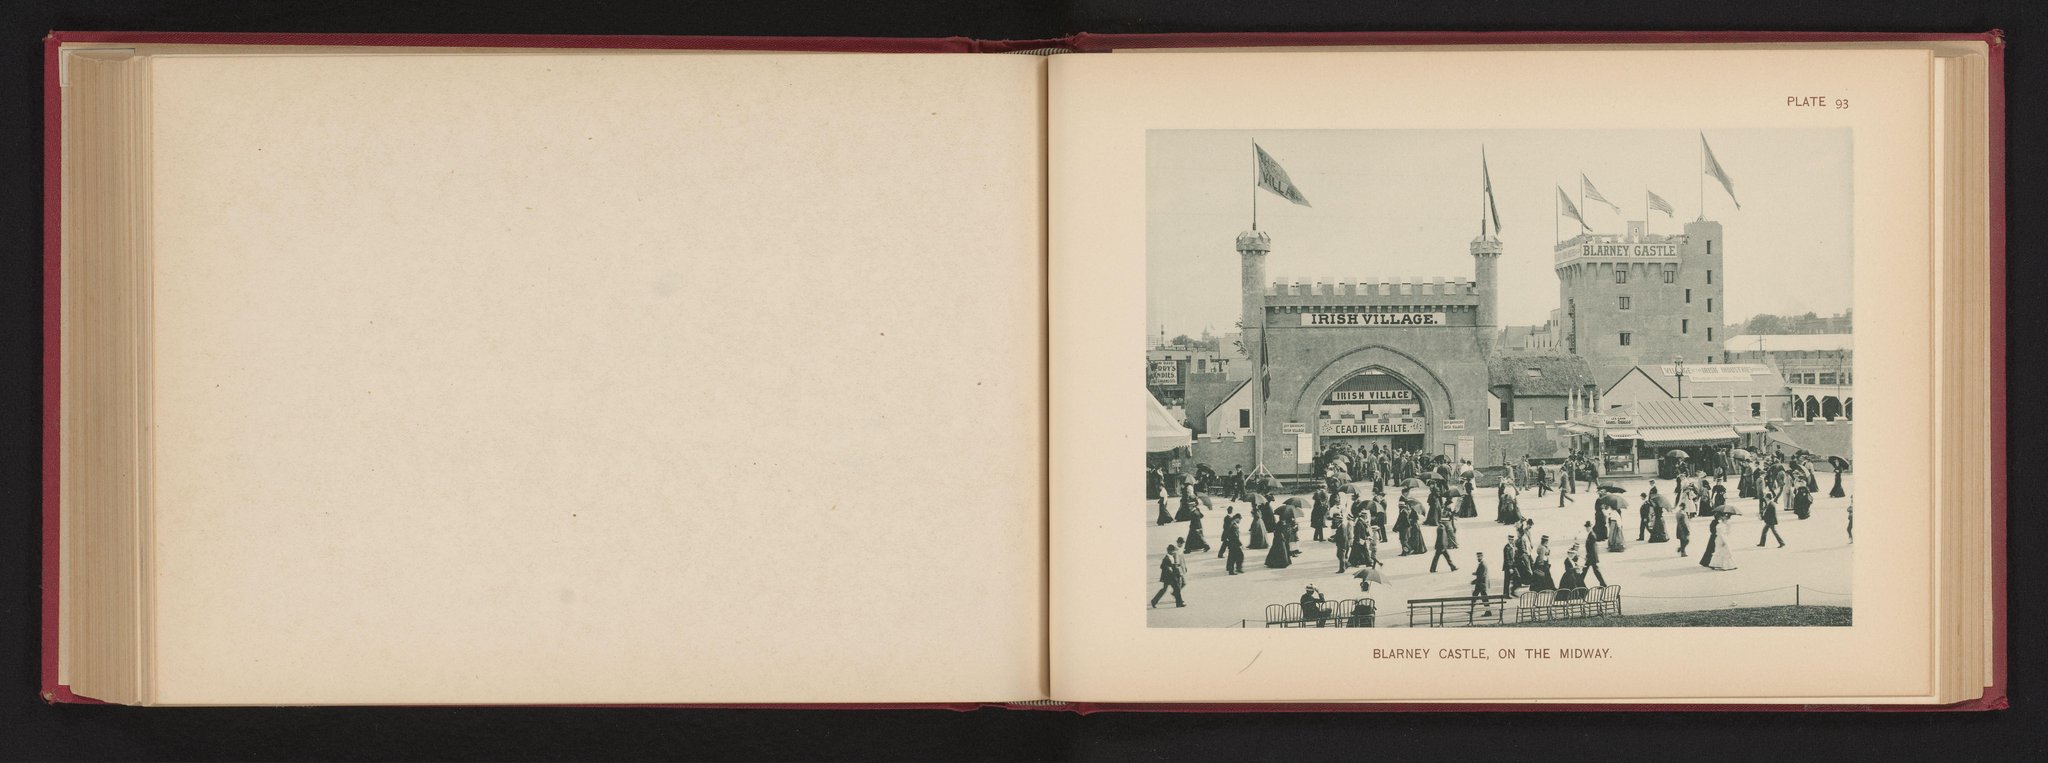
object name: photomechanical print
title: Gezicht op de bijdrage van Ierland met een replica van het Blarney Castle op de World's Columbian Exposition in Chicago in 1893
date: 1893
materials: paper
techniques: photograph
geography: chicago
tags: castle, world fair, world exhibition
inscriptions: number: ‘Plate 93’